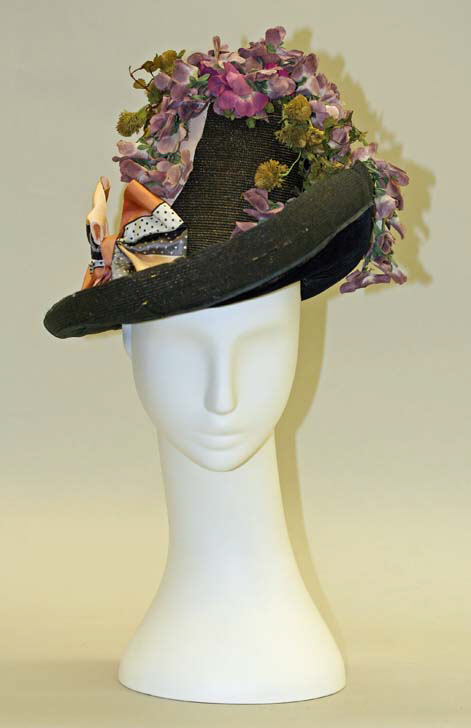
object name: hat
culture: american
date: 1886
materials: fiber